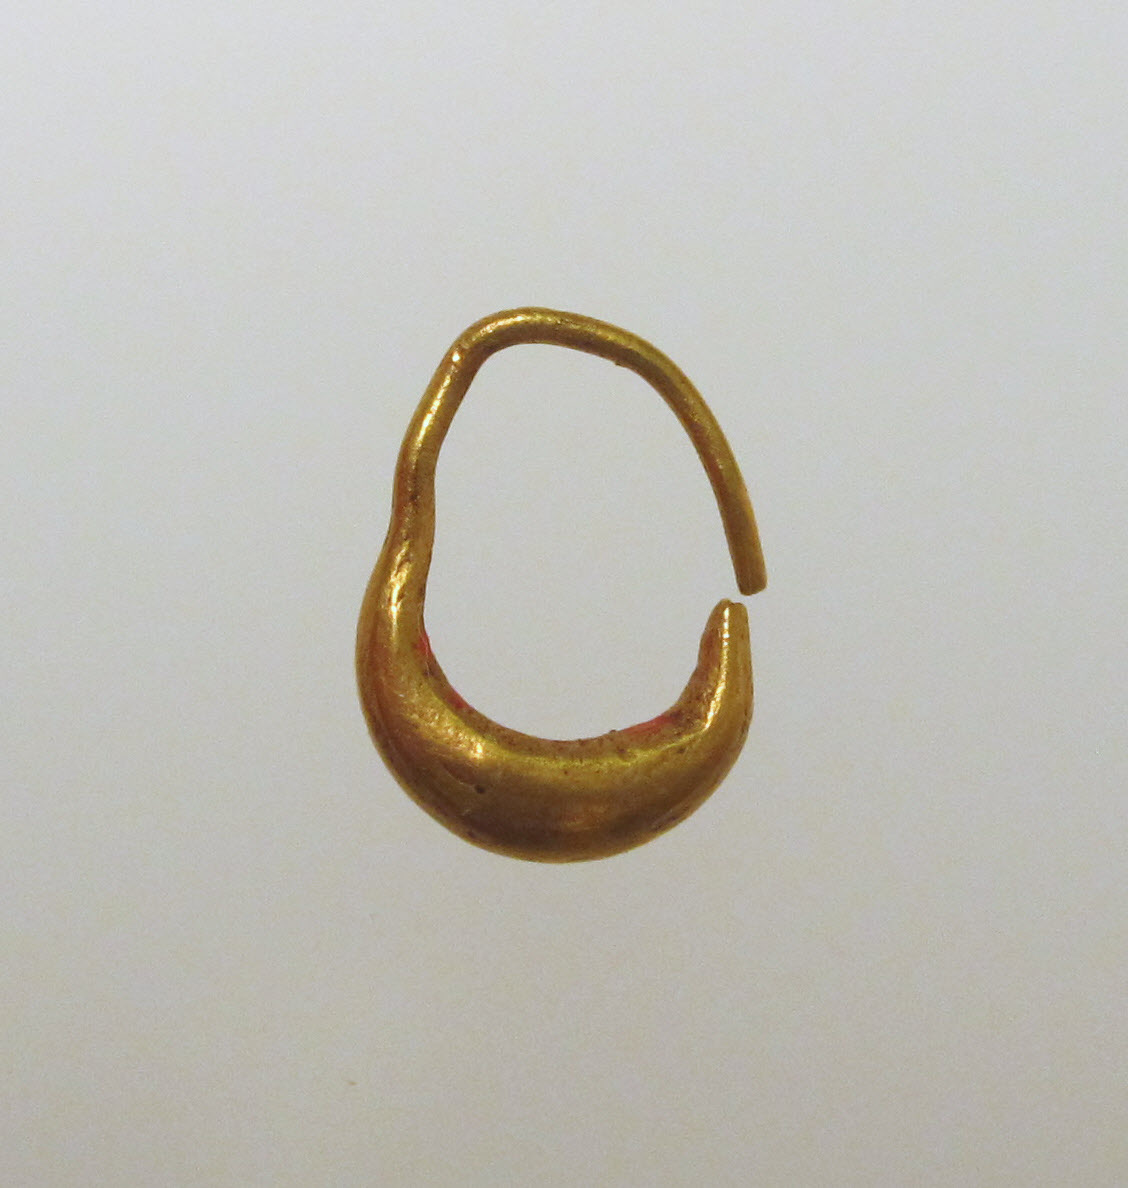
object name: earring, boat shaped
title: Earring, boat-shaped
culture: cypriot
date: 3900 BCE-100 CE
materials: gold